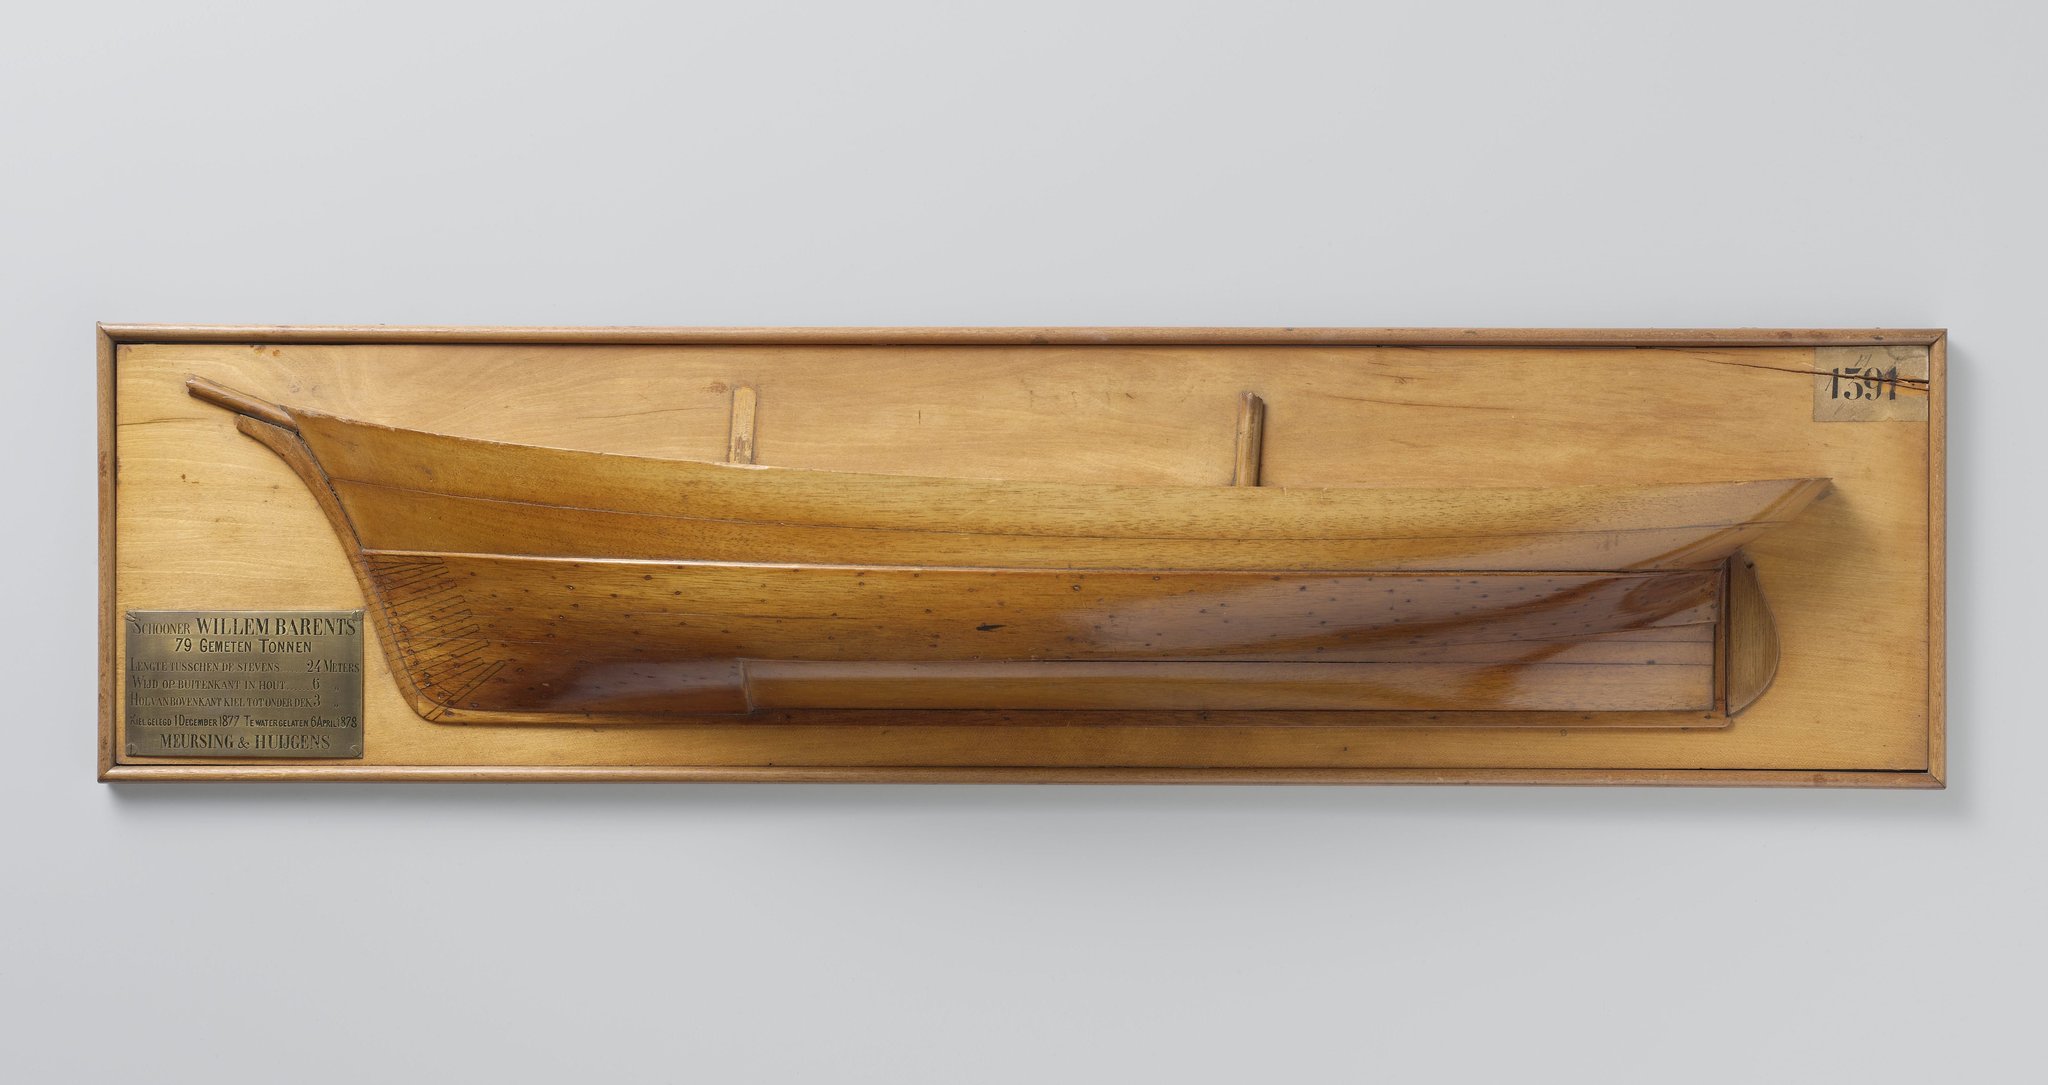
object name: half model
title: Half Model of a Schooner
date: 1877-1878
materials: wood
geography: amsterdam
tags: sailing-ship, sailing-boat (schooner)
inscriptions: label, top right: ‘1391’ former inventory label, inscription, bottom left, on a square metal label: ‘SCHOONER WILLEM BARENTS / 79 GEMETEN TONNEN / [followed by measurements] / KIEL GELEGD 1 DECEMBER 1877 TE WATER GELATEN 6 APRIL 1878 / MEURSING & HUIJGENS’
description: Halfmodel van de poolschoener Willem Barents, 79 ton, gebouwd op de werf van Meursing en Huijgens te Amsterdam, met de kiellegging op 1 december 1877 en tewaterlating op 6 april 1878.